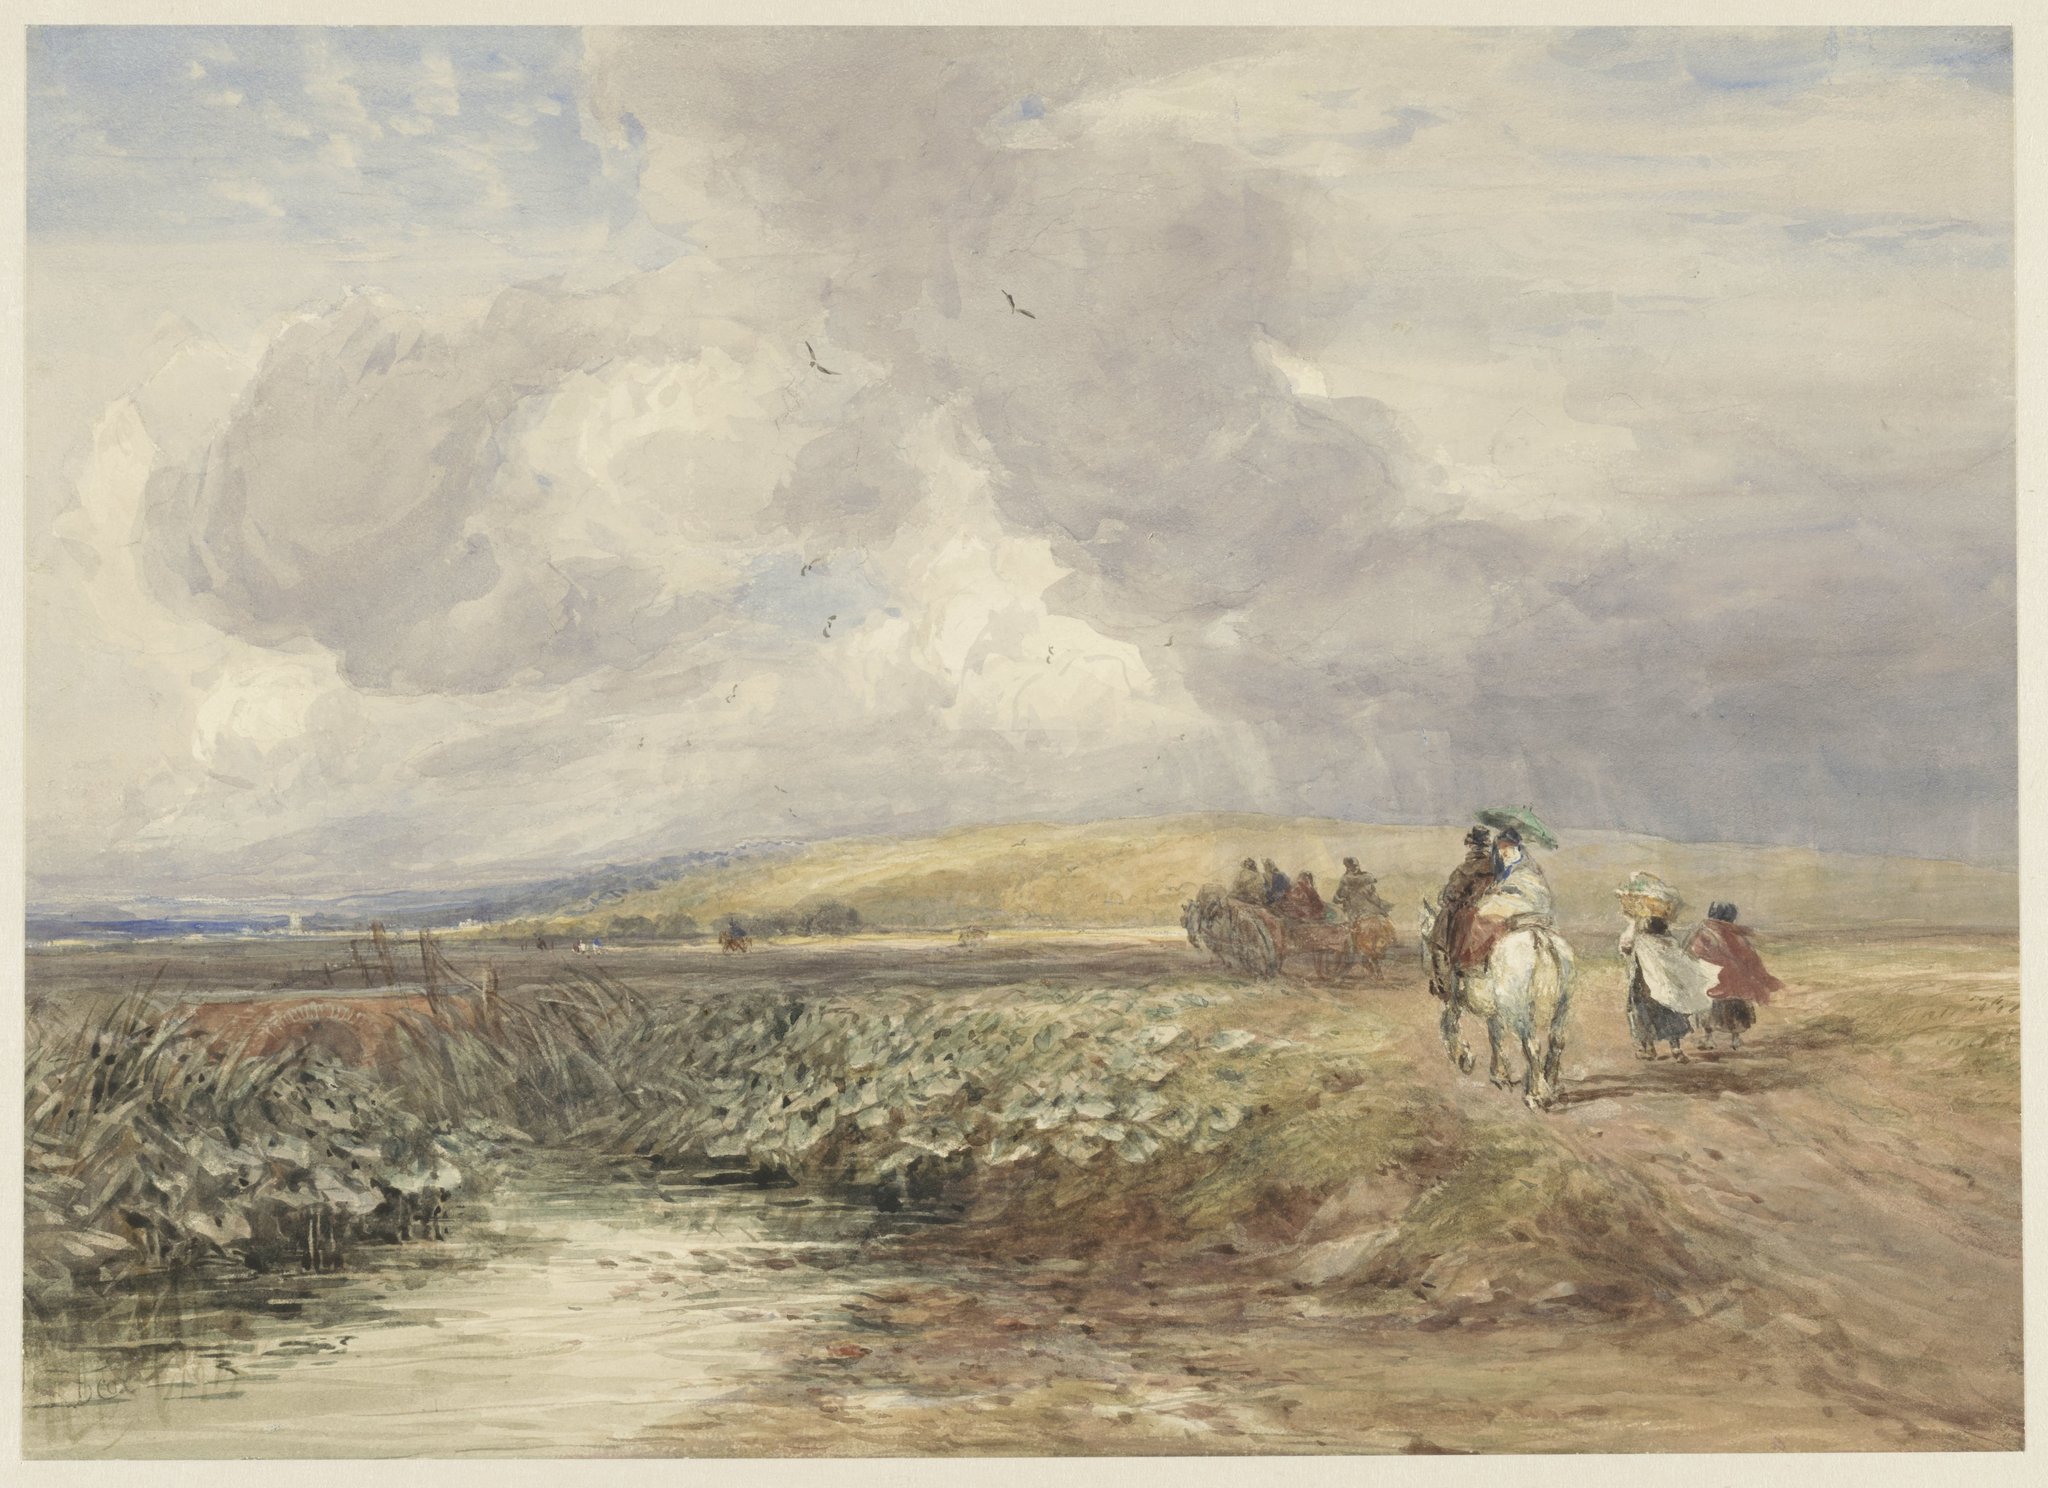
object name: drawing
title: Landschap met reizigers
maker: david cox (i)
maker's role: draughtsman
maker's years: 1783-1859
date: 1793-1859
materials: paper, pencil, watercolor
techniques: brush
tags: low hill country (+ landscape with figures, staffage), 'en route', traveller under way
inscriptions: signature: ‘D. Cox’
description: Wandelaars, ruiters en een wagen in een winderig landschap (Noord-Wales).